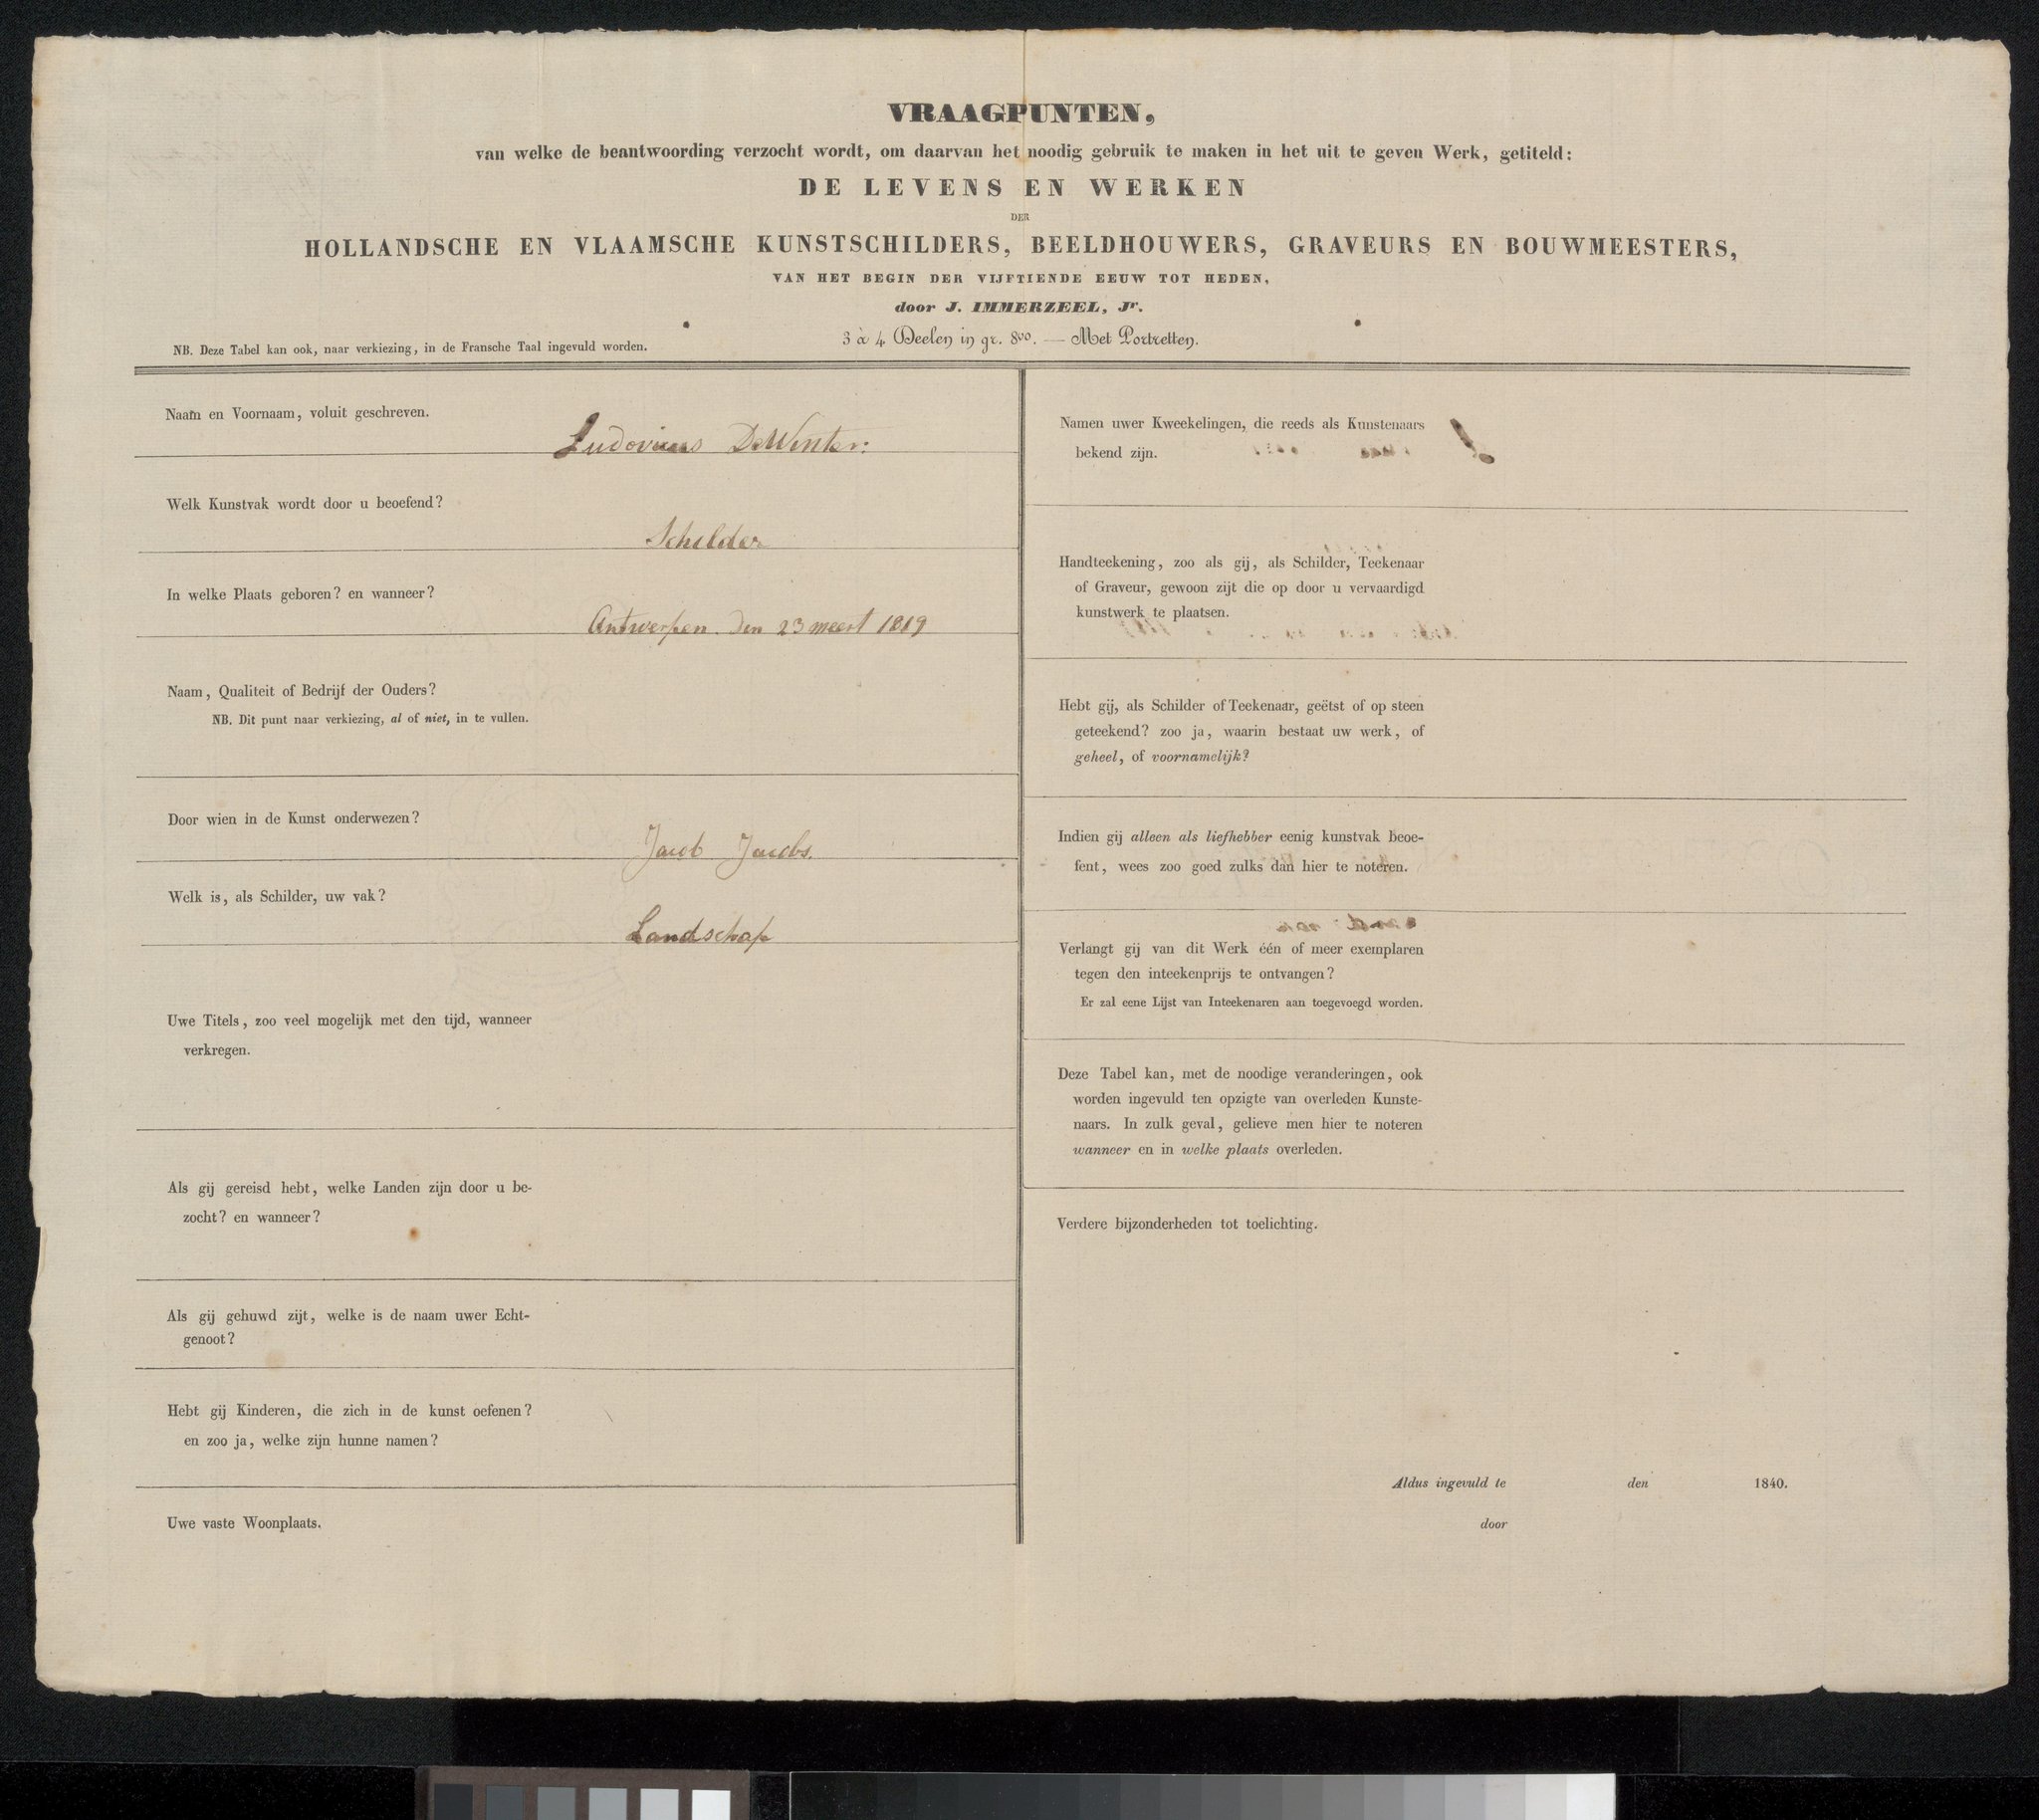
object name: questionnaire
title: Enquêteformulier ingevuld door Louis De Winter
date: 1840-1841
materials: ink, paper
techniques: pen, printing, writing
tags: antwerp, painter, louis de winter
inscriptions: watermark, inscription: ‘Vraagpunten,/ van welke de beantwoording verzocht wordt, om daarvan het noodig gebruik te maken in het uit te geven Werk, getiteld: De levens en werken/ der Hollandsche en Vlaamsche kunstschilders, beeldhouwers,/ graveurs en bouwmeesters, van het begin der vijftiende eeuw tot heden/ door J. Immerzeel, Jr.’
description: Opgenomen in: Immerzeel, J. Jr., De levens en werken der Hollandsche en Vlaamsche kunstschilders, beeldhouwers, graveurs en bouwmeesters, van het begin der vijftiende eeuw tot heden, Amsterdam: J.C. van Kesteren, 1842-1843.